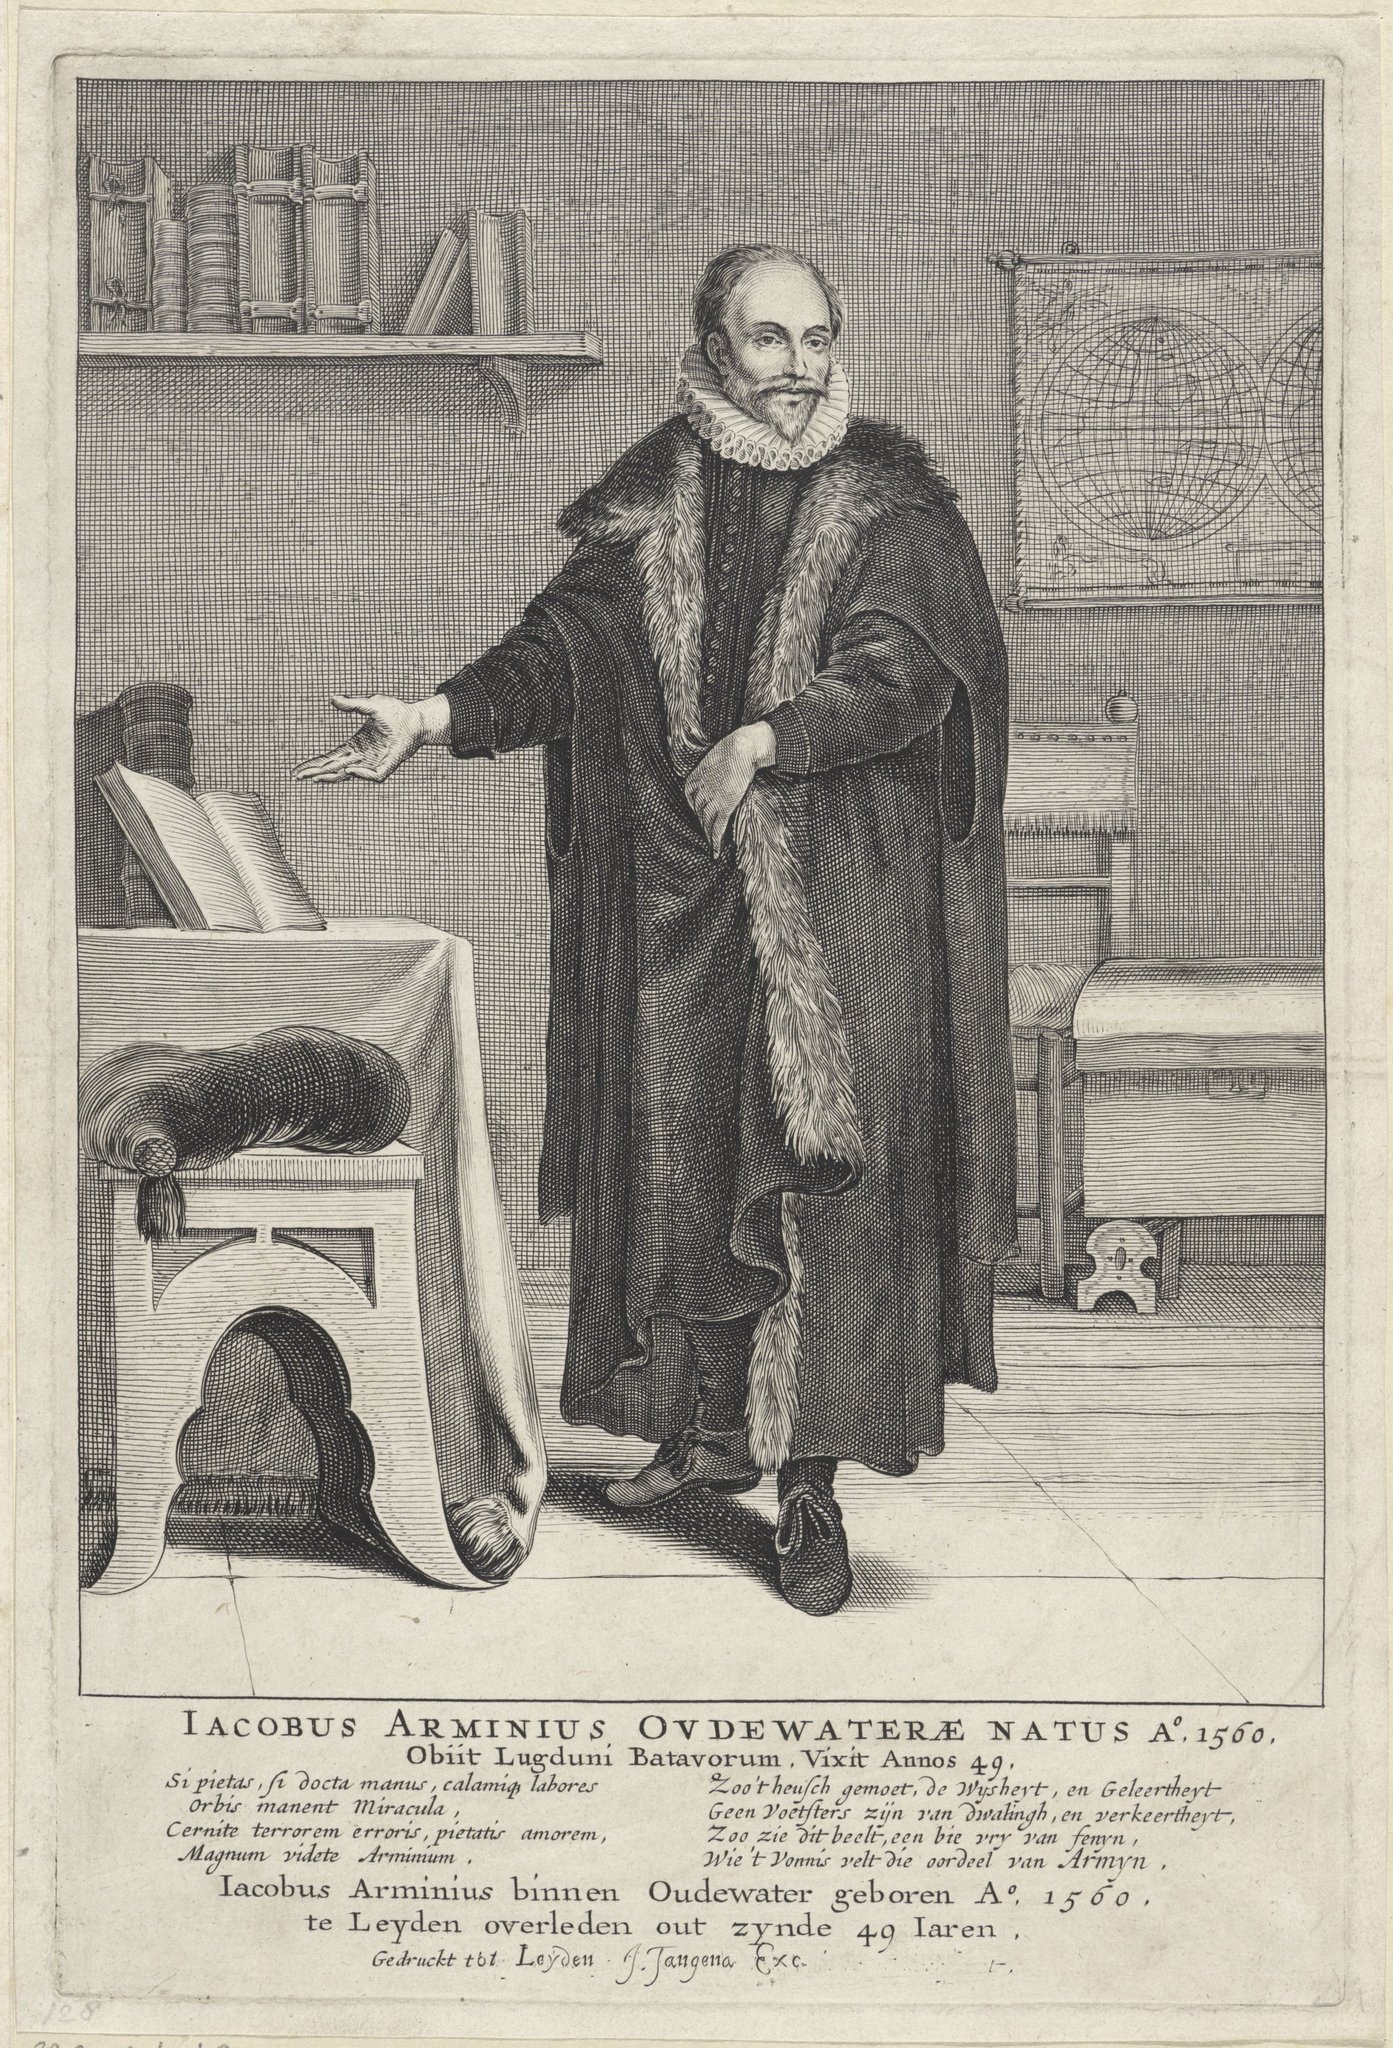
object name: print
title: Portret van Jacobus Arminius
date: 1643-1652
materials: paper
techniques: engraving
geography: leiden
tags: scholar in his study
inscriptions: collector's mark: Lugt 2228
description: Portret van Jacobus Arminius, theoloog en leider van de remonstranten, staande in zijn studeerkamer. Hij wijst op een opengeslagen boek. Aan de wand een plank met boeken en een wereldkaart. Onderaan in de marge een vierregelig vers in het Latijn en in het Nederlands.